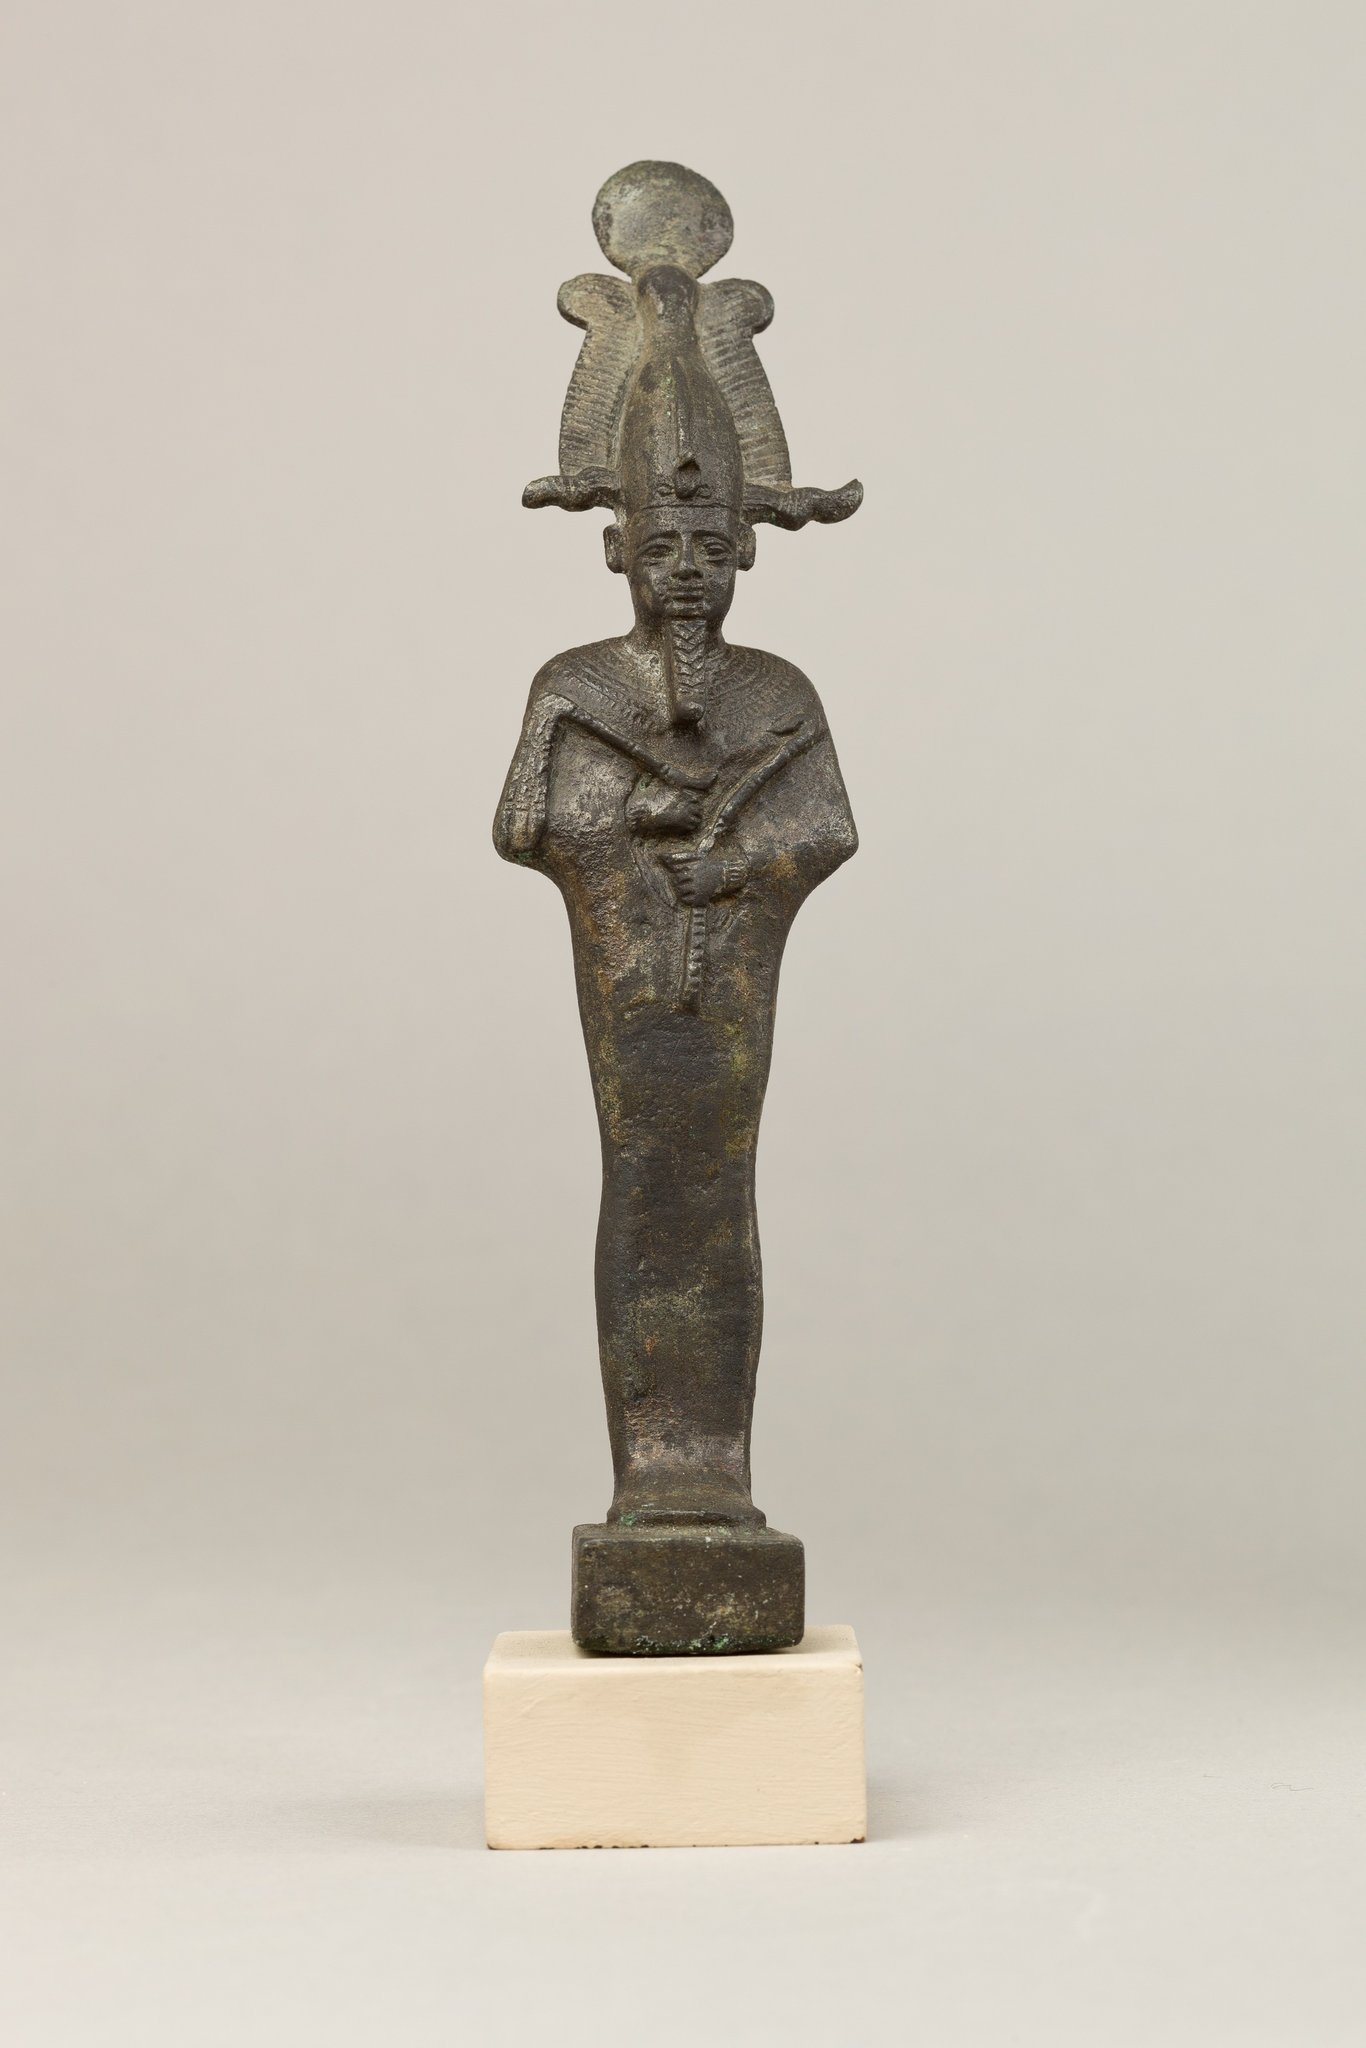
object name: statuette, osiris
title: Osiris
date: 664-630 BCE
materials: metal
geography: egypt